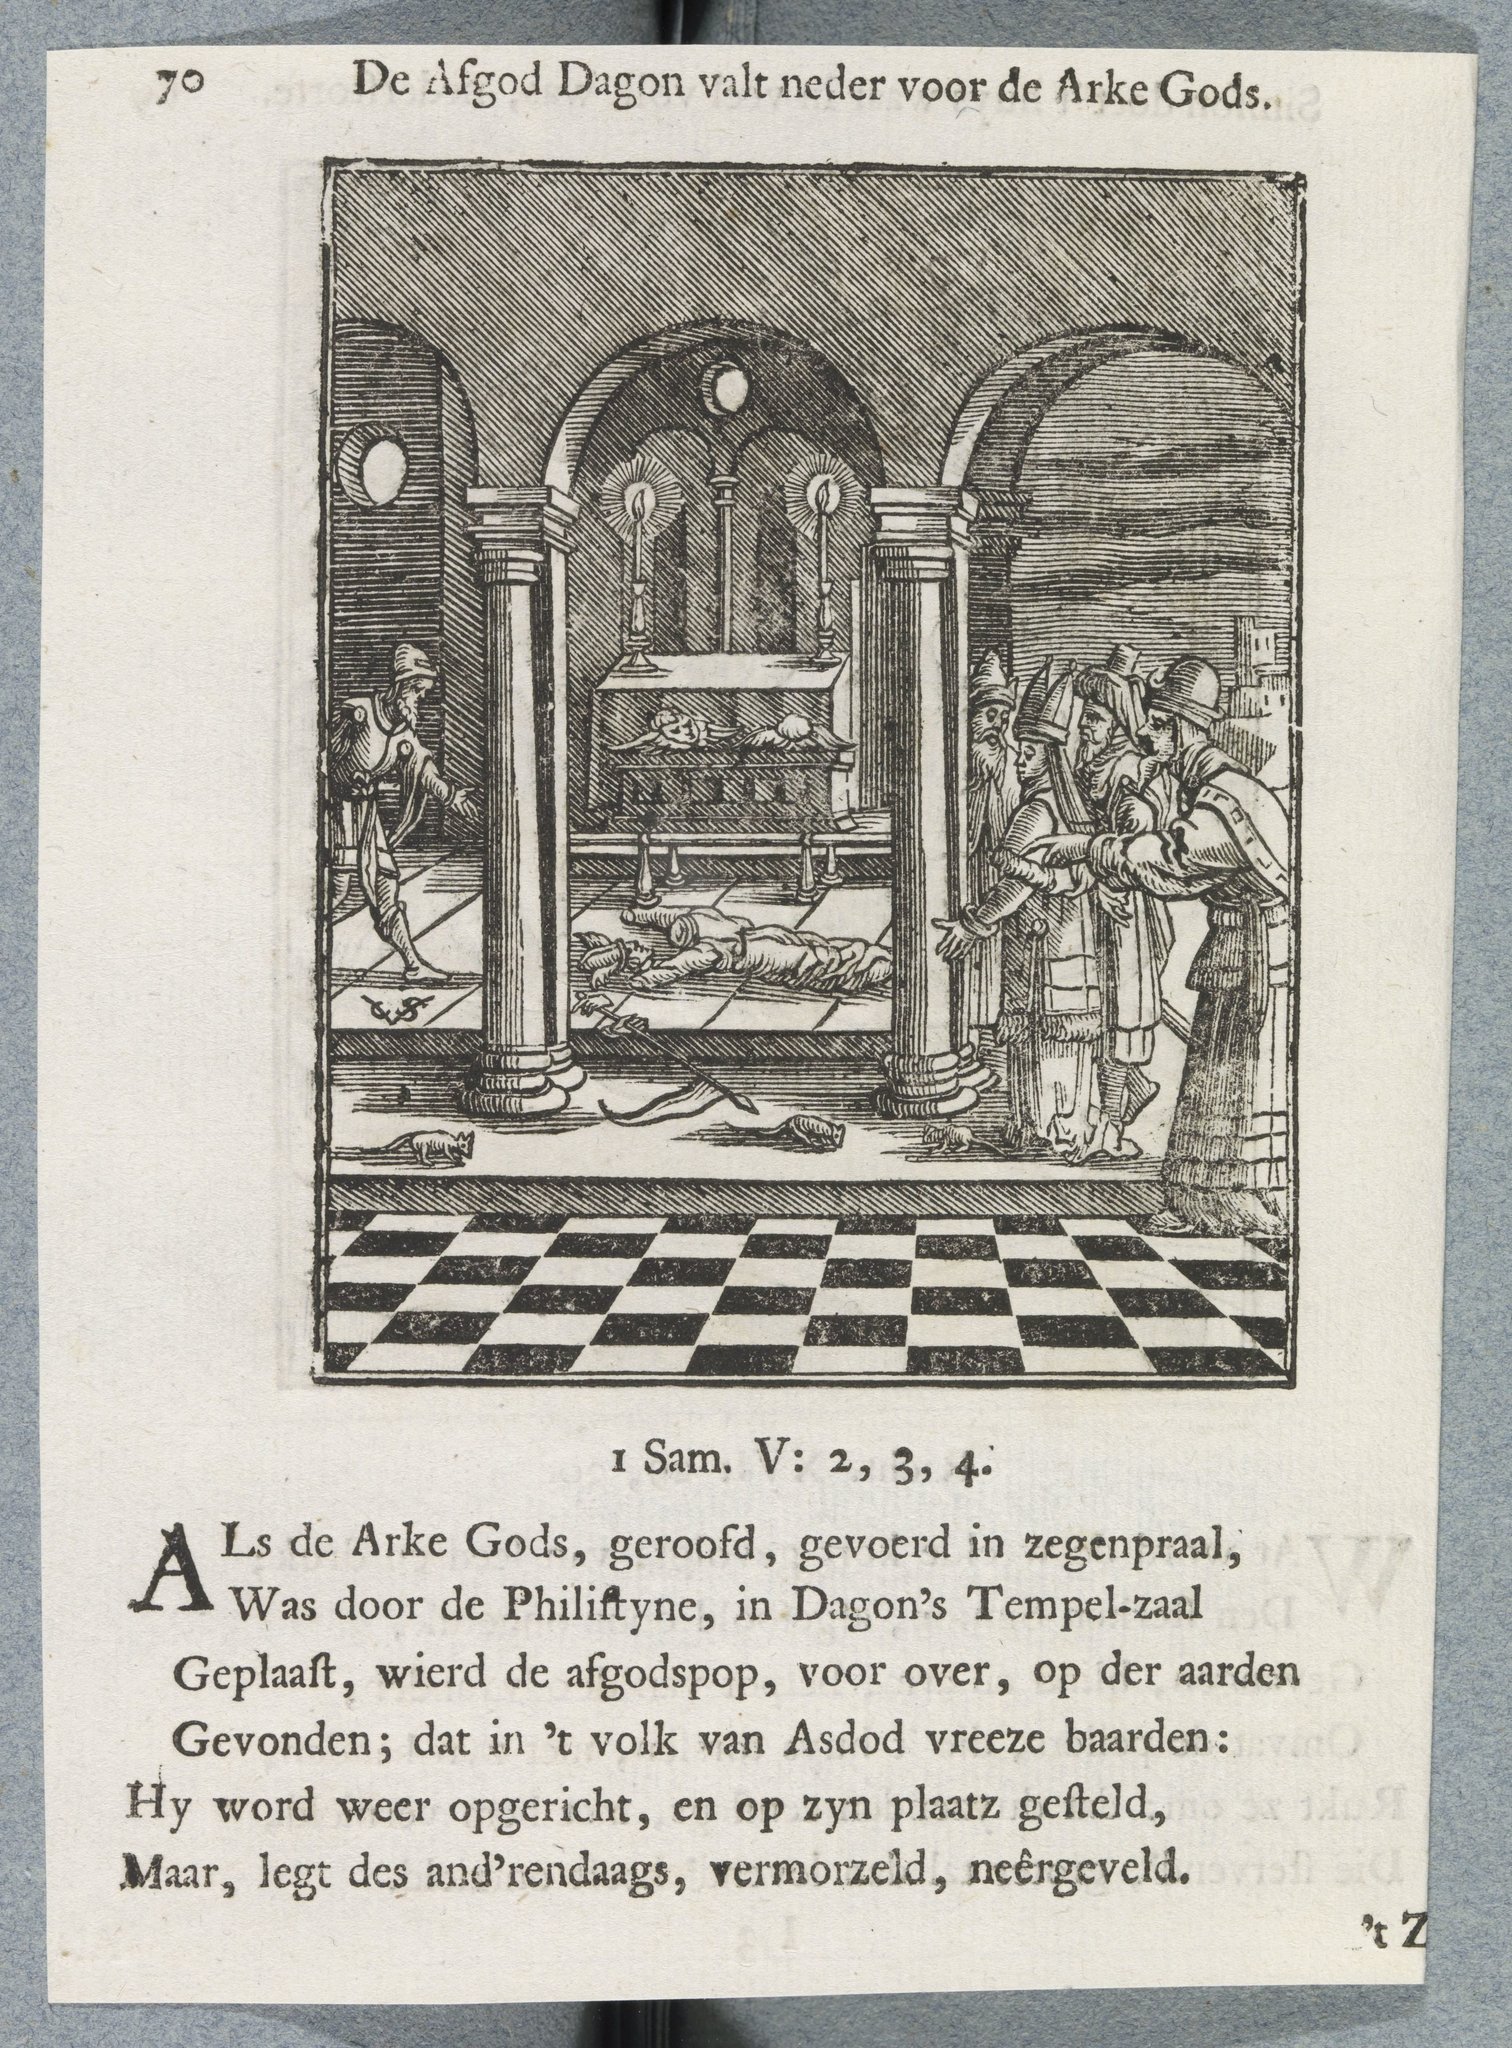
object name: album leaf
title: De afgod Dagon valt neder voor de arke Gods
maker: jan klooster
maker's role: bookseller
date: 1645-1646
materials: paper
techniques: letterpress printing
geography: amsterdam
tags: the statue of dagon in ashdod falls down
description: De prent is afkomstig uit: Bybels Lusthof. Amsterdam, J. Klooster, 1740. De prent werd gemaakt voor de uitgaven van P.J. Paets uit Amsterdam. Ze komt in ieder geval voor in: Bibels Tresoor ofte der zielen lusthof. Amsterdam, P.J. Paets, 1646. Mogelijk staat ze ook in: Historien ende Prophetien. [Amsterdam], P.J. Paets, 1645.